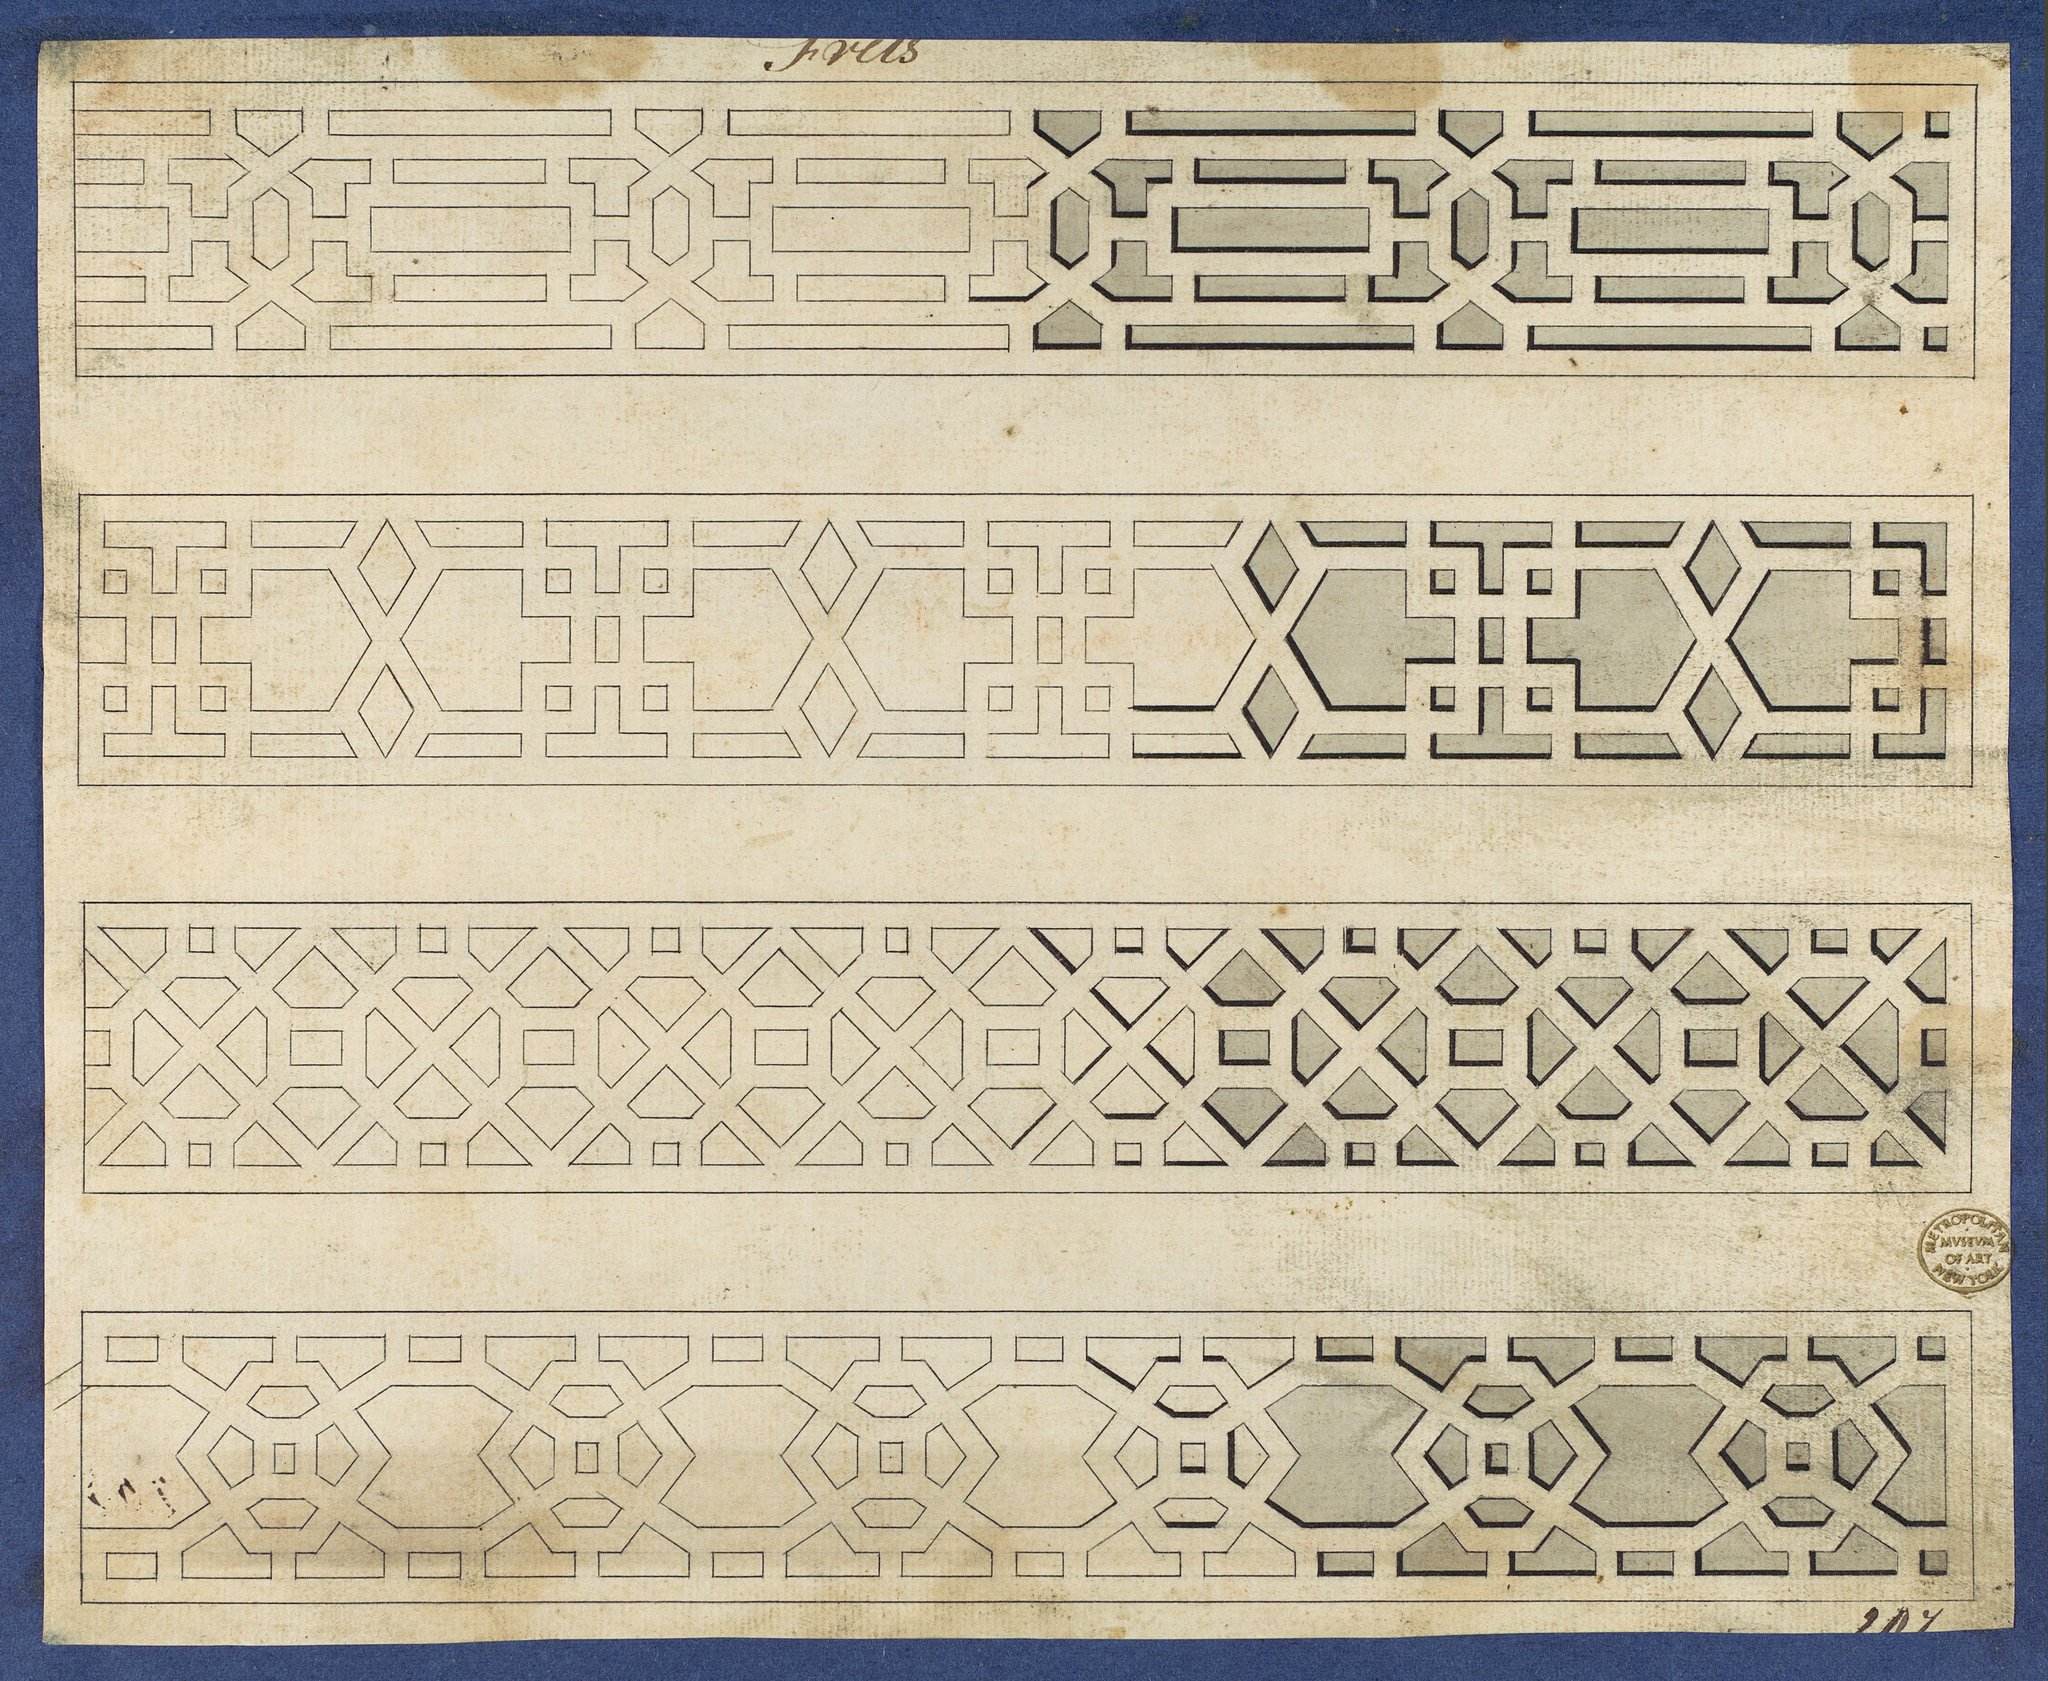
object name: drawing ornament architecture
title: Frets, from Chippendale Drawings, Vol. II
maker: thomas chippendale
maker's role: artist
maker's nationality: british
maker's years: 1718-1779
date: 1754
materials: ink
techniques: wash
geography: london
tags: ornament